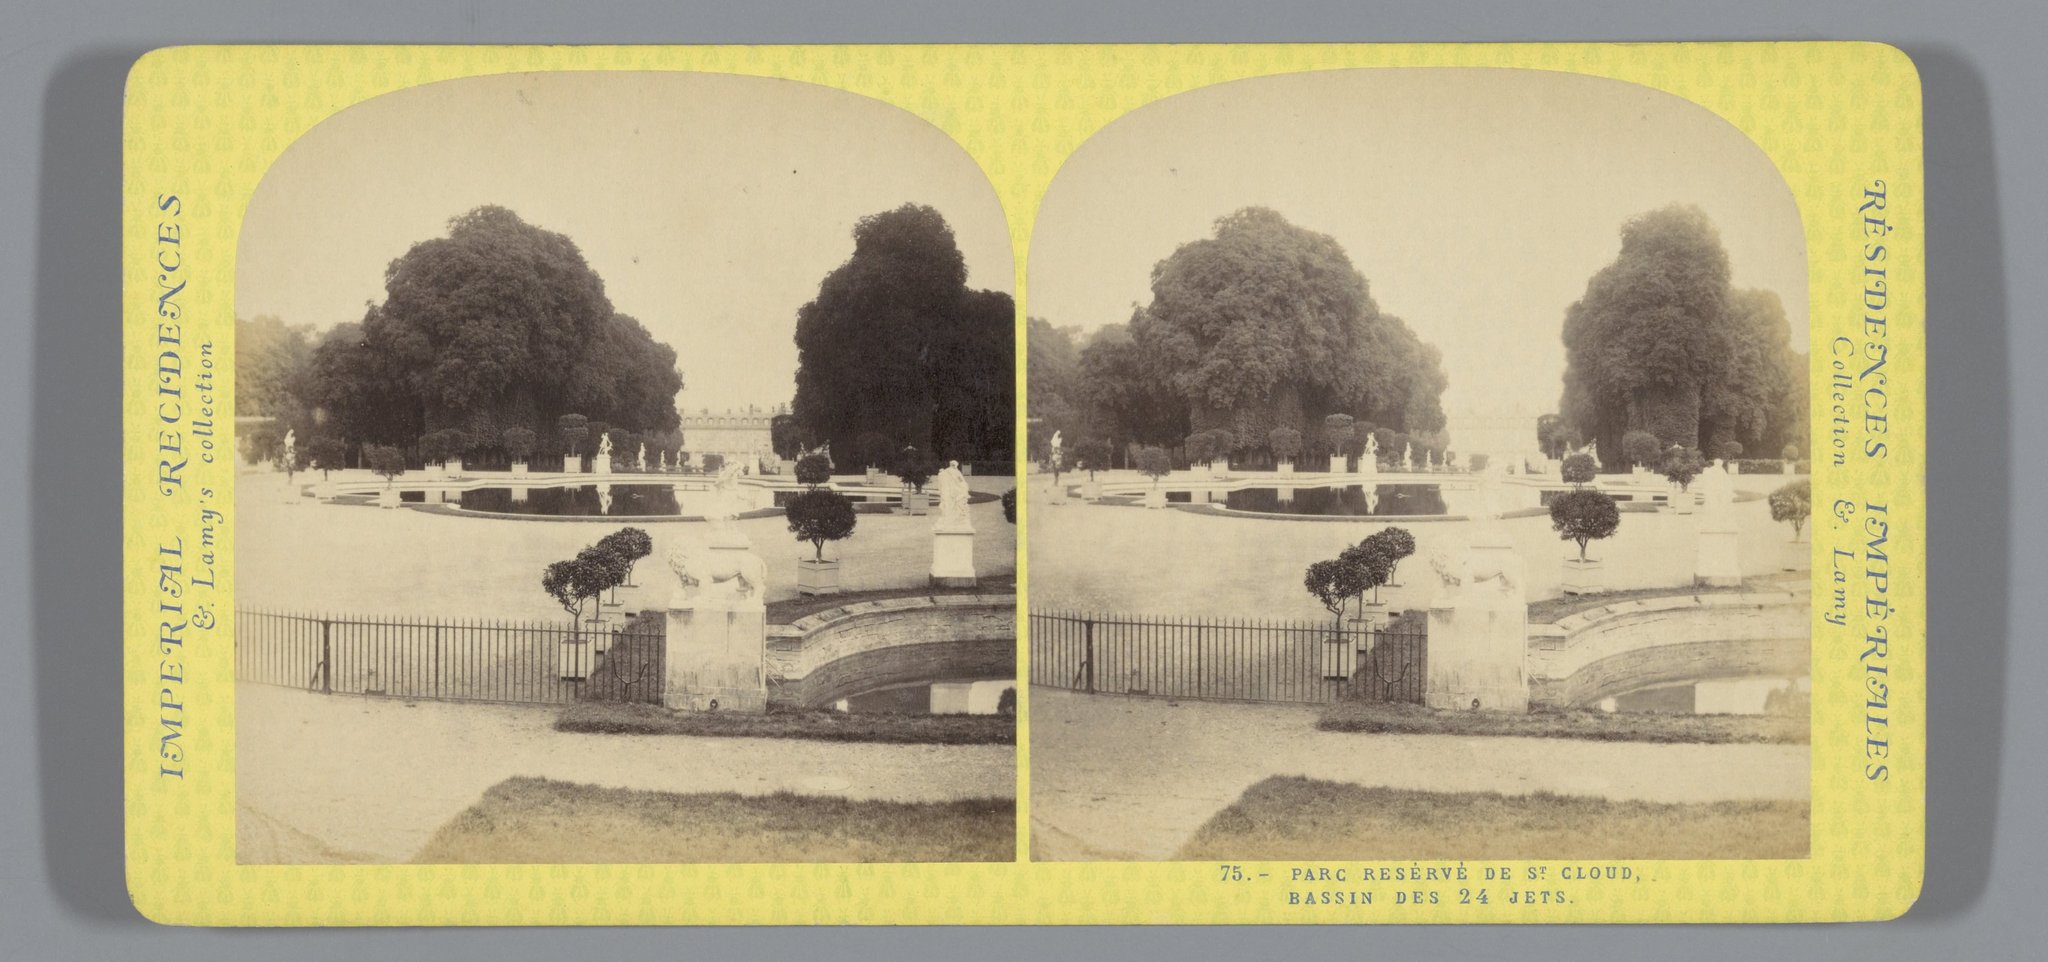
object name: stereograph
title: Imperial Residences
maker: ernest eléonor pierre lamy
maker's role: publisher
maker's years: 1828-1900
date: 1860-1870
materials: cardboard, photographic support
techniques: albumen print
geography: parc de saint-cloud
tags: garden pond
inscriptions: number: ‘75.’, inscription: ‘E. Lamy's collection’